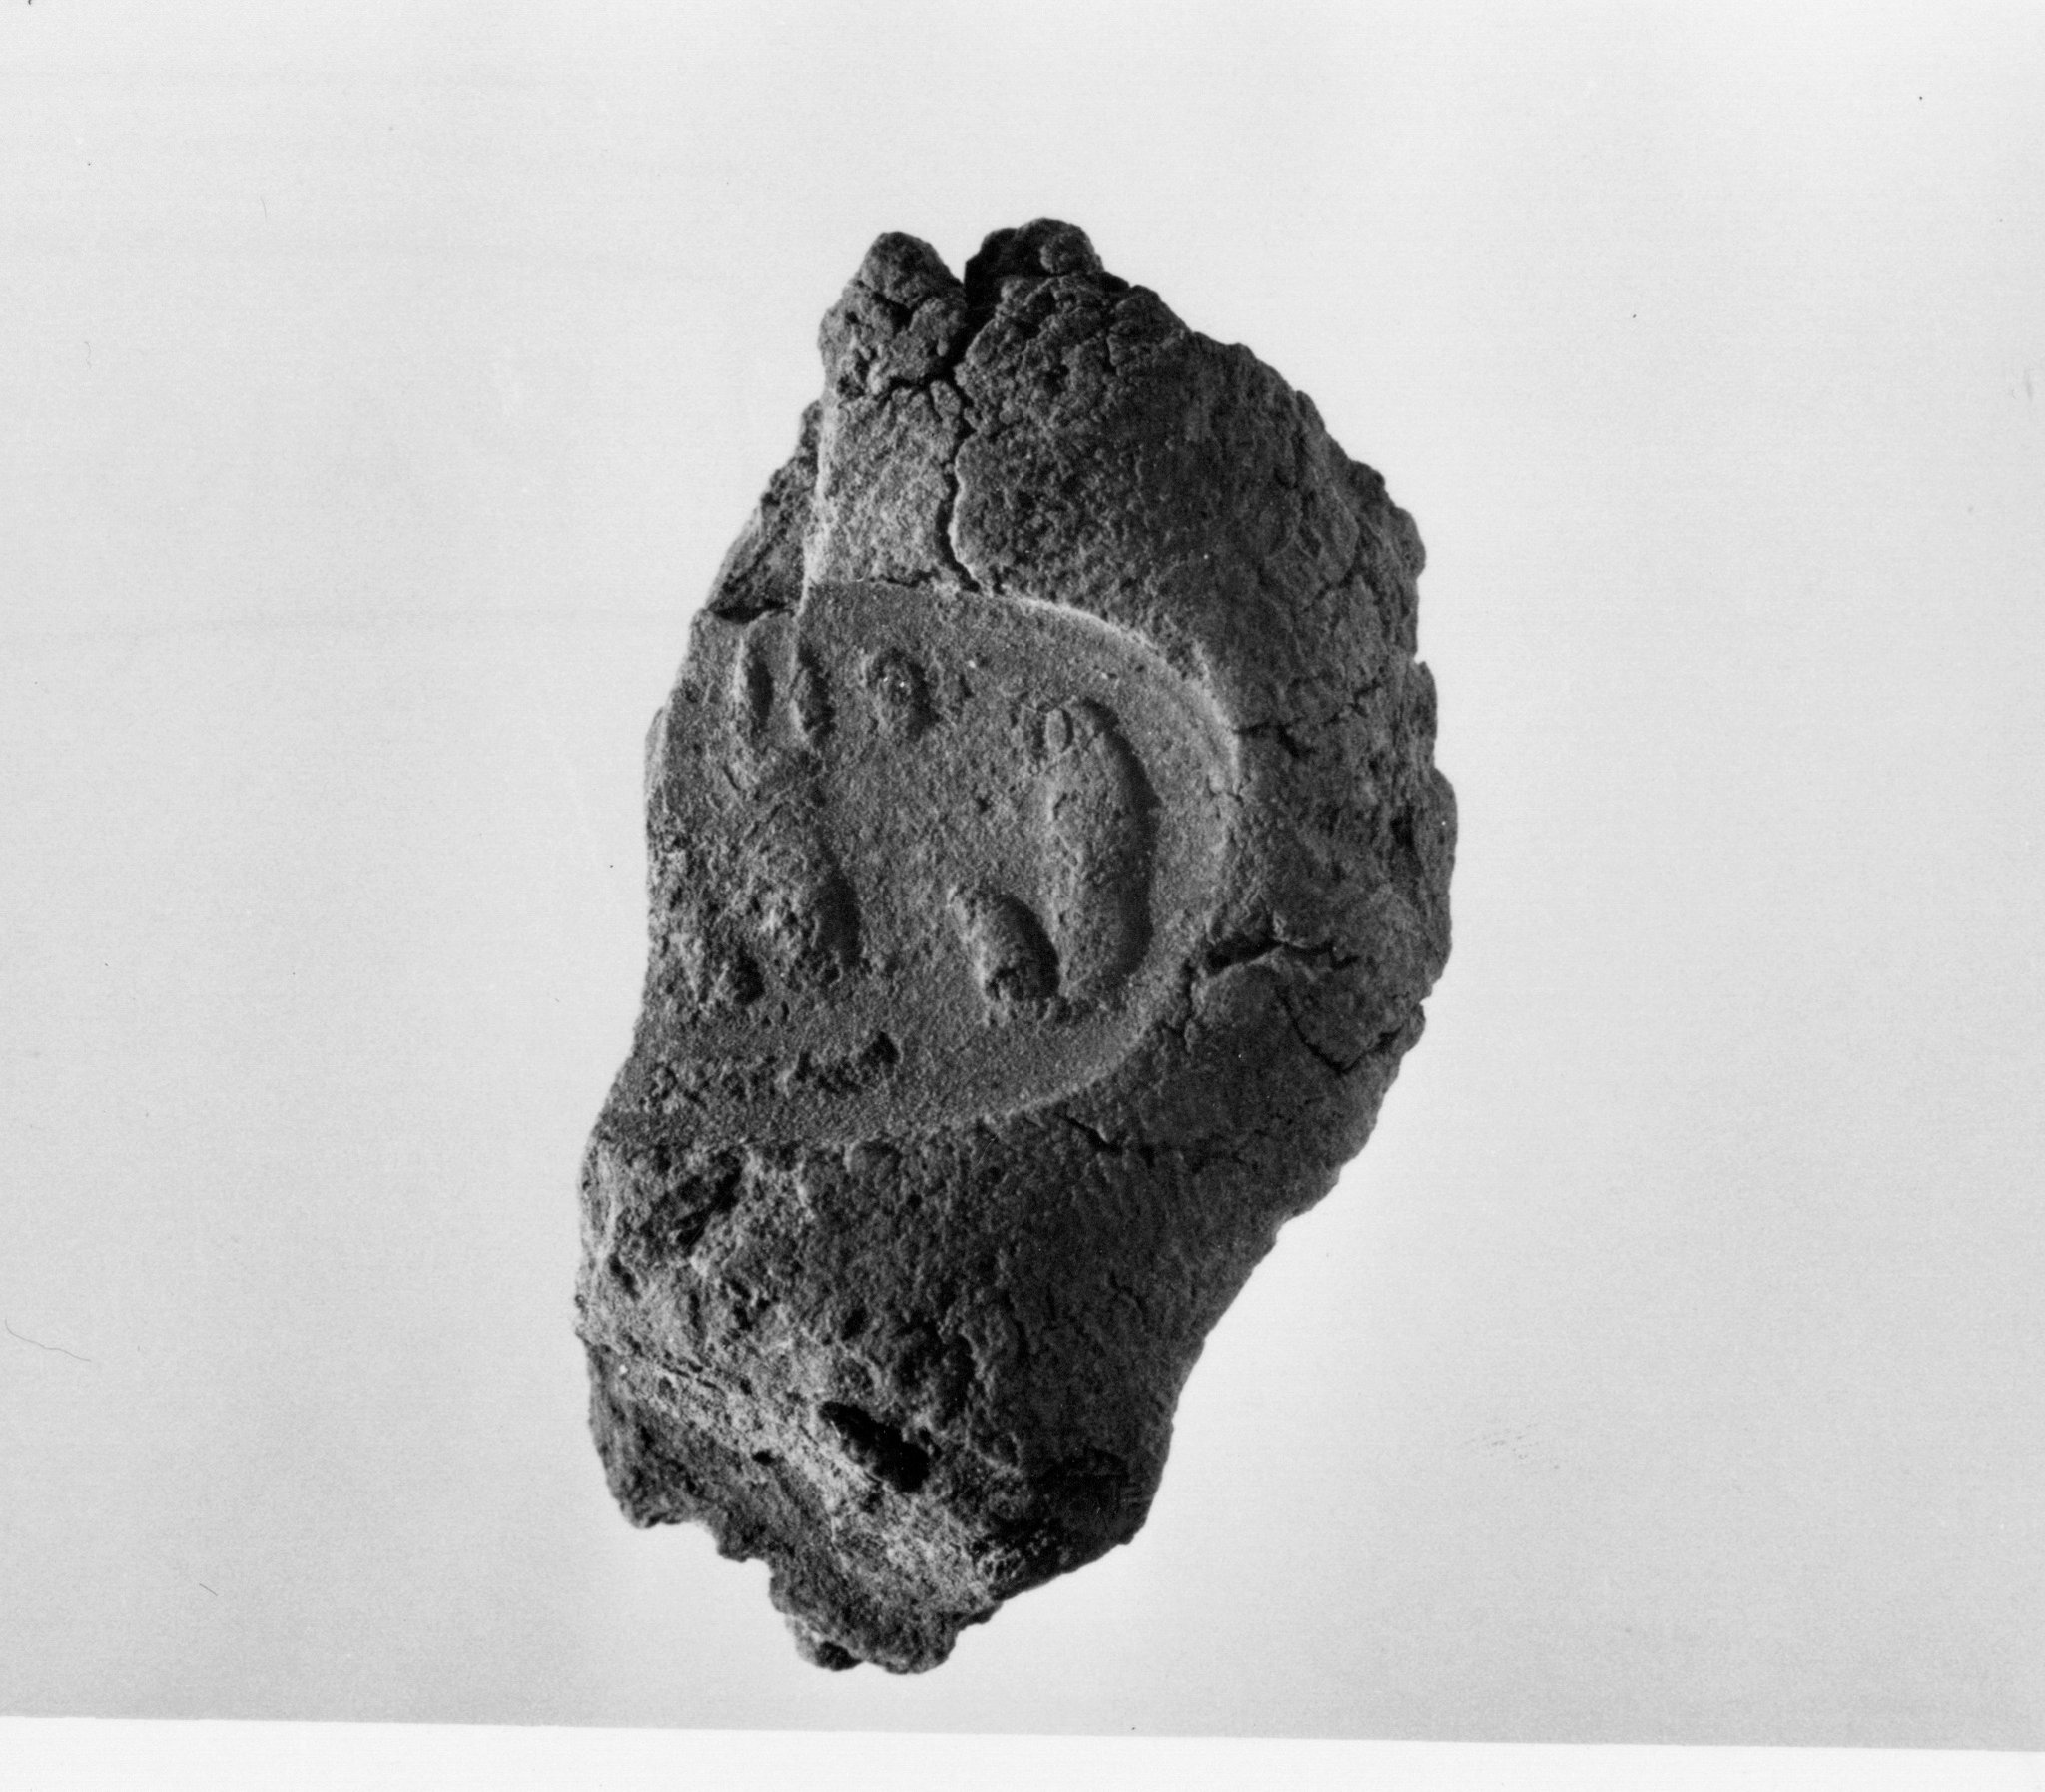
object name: sealing, nebmaatre, amenhotep iii, horus, re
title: Document Sealing With the Throne Name of Amenhotep III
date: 1390-1352 BCE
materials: mud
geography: egypt